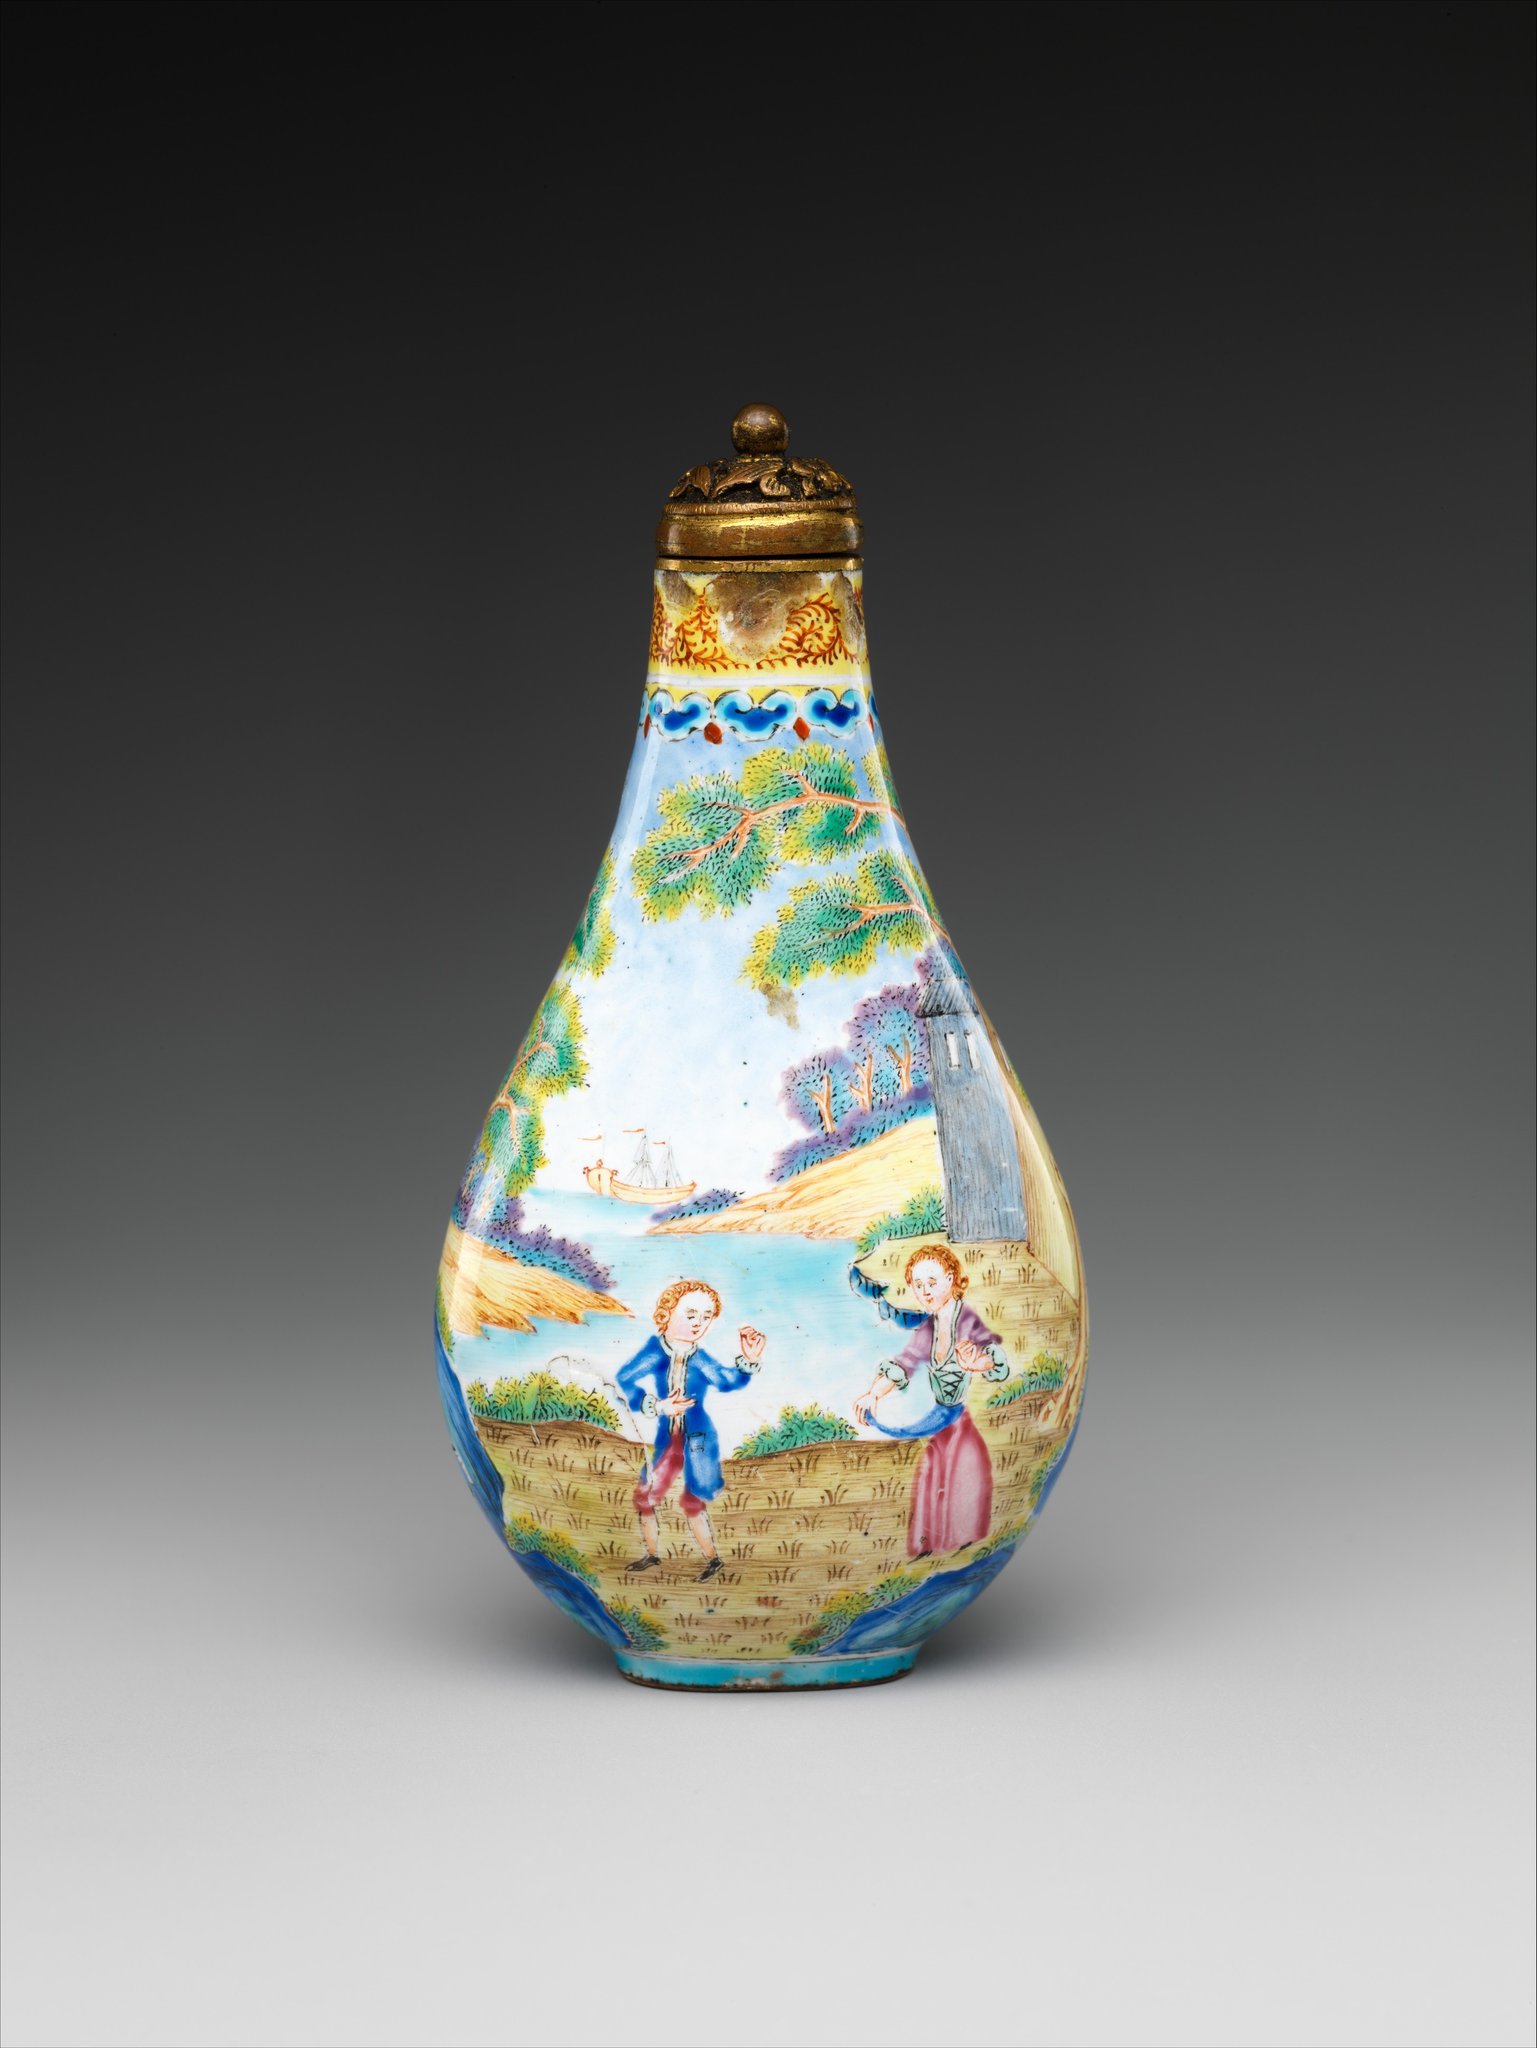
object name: snuff bottle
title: Snuff bottle with European figures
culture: chinese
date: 1736-1795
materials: copper, enamel, gilt bronze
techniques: painting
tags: men,women,ships